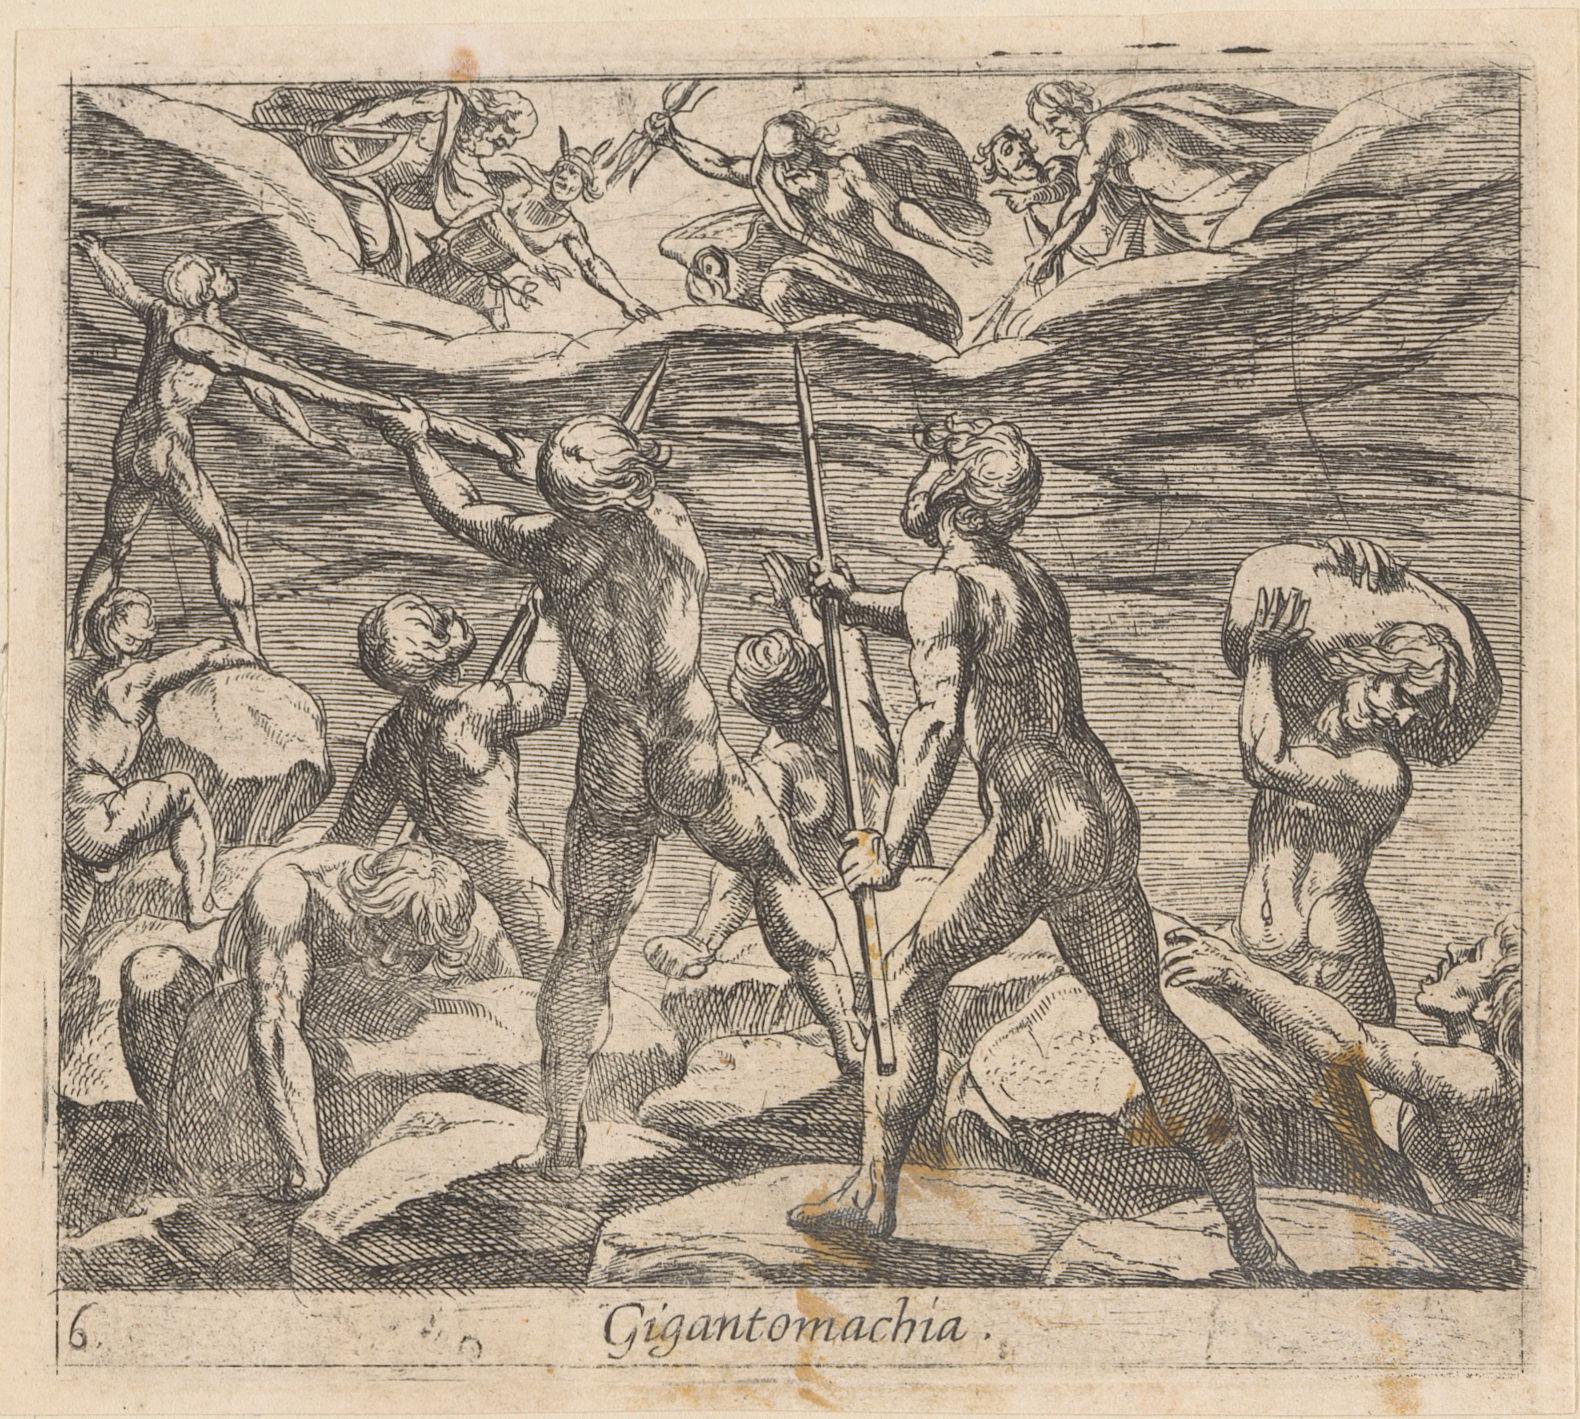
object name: print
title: Metamorfosen van Ovidius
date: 1606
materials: paper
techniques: etching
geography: antwerp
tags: the aloeids try to reach heaven by piling mount ossa and mount pelion on olympus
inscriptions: collector's mark: Lugt 240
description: Deze prent maakt deel uit van een reeks van 150 prenten (+ titelprent) met voorstellingen van de Metamorfosen van Ovidius.